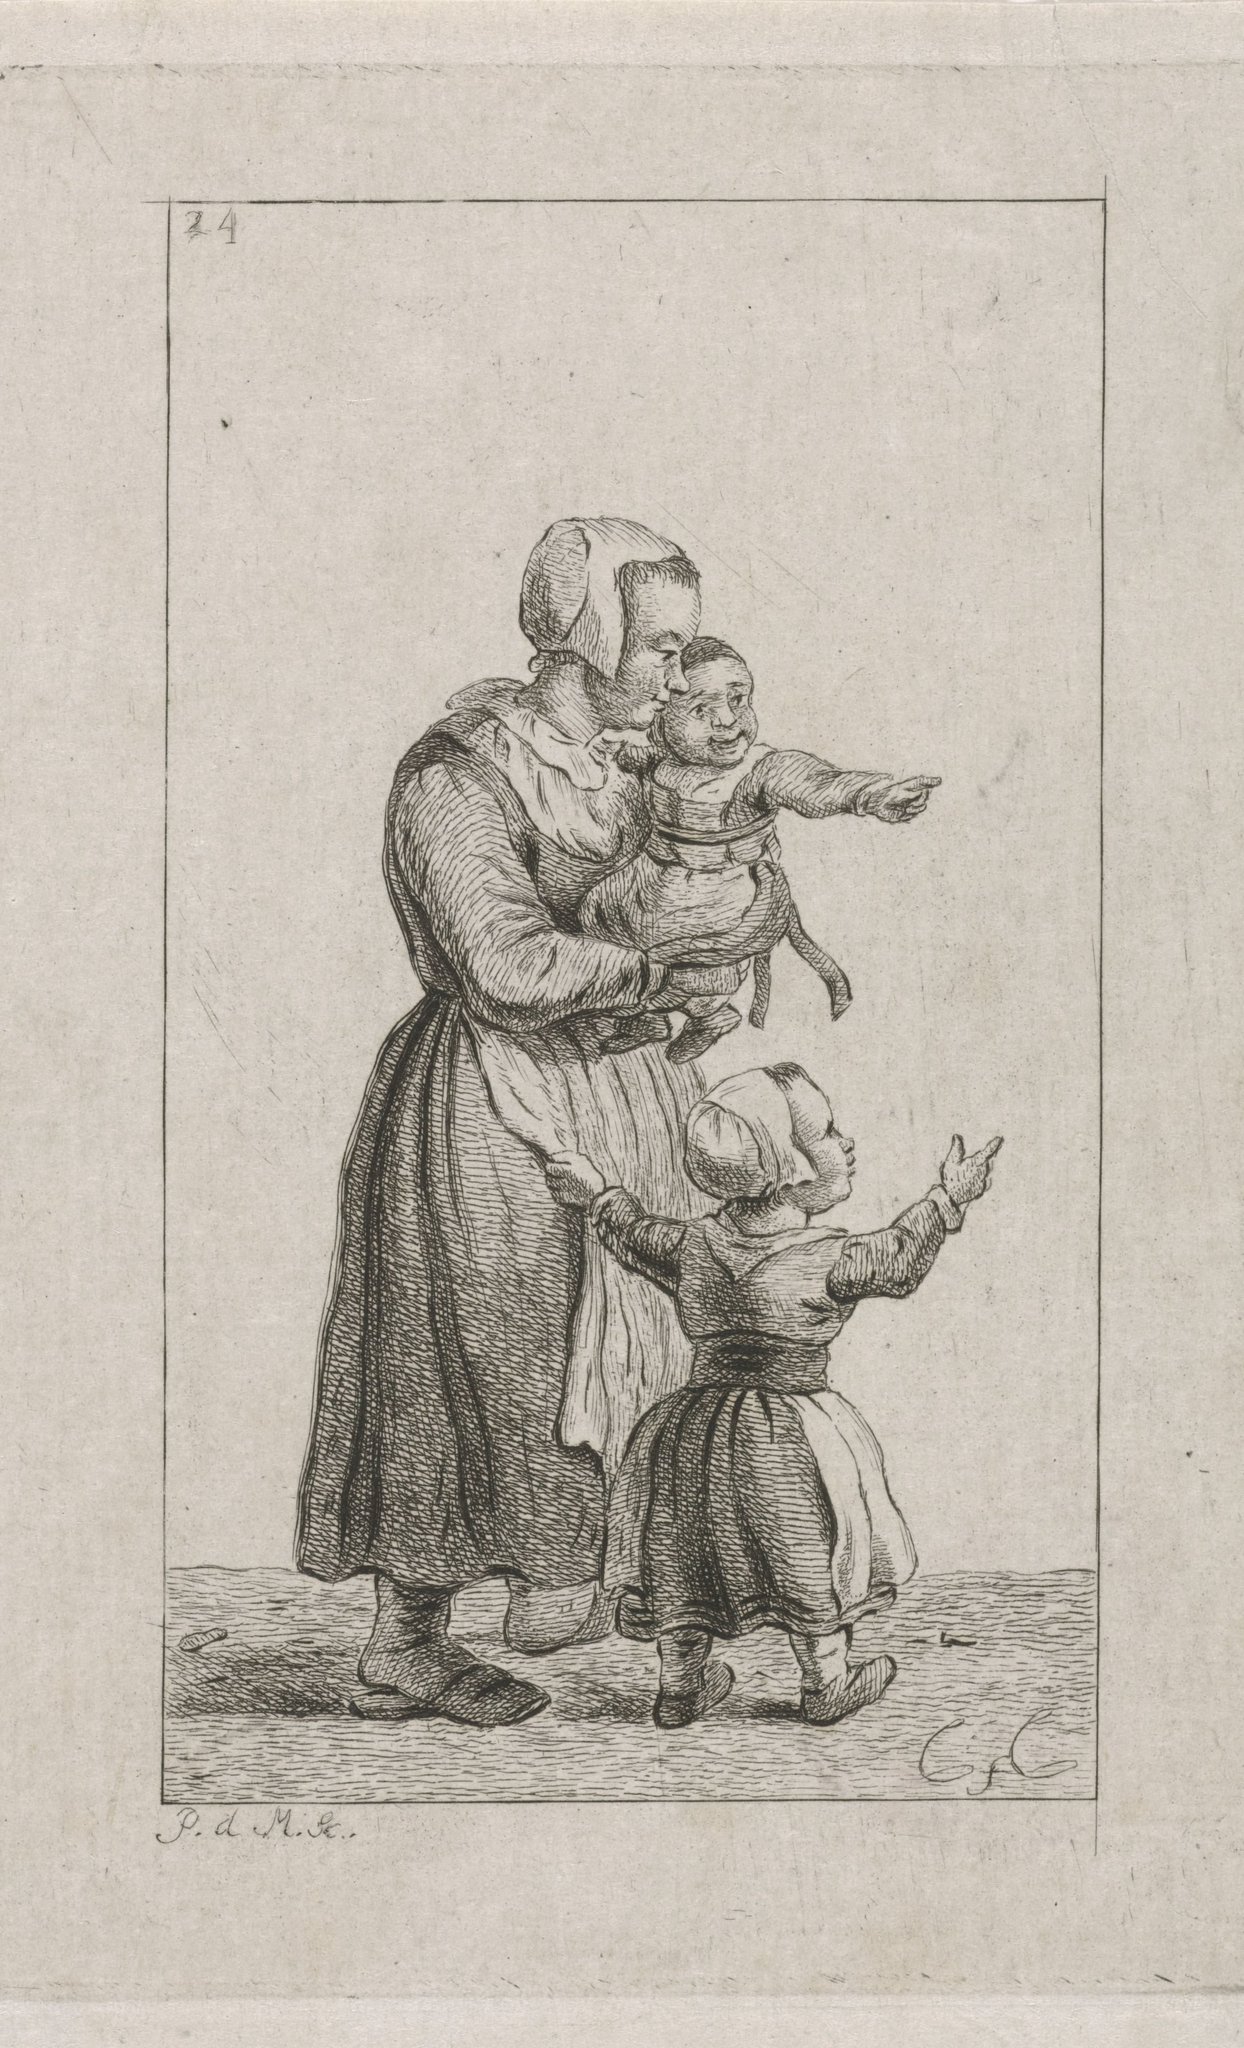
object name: print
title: Moeder met twee kinderen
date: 1779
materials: paper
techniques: etching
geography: leiden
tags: mother and baby or young child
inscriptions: collector's mark: Lugt 240